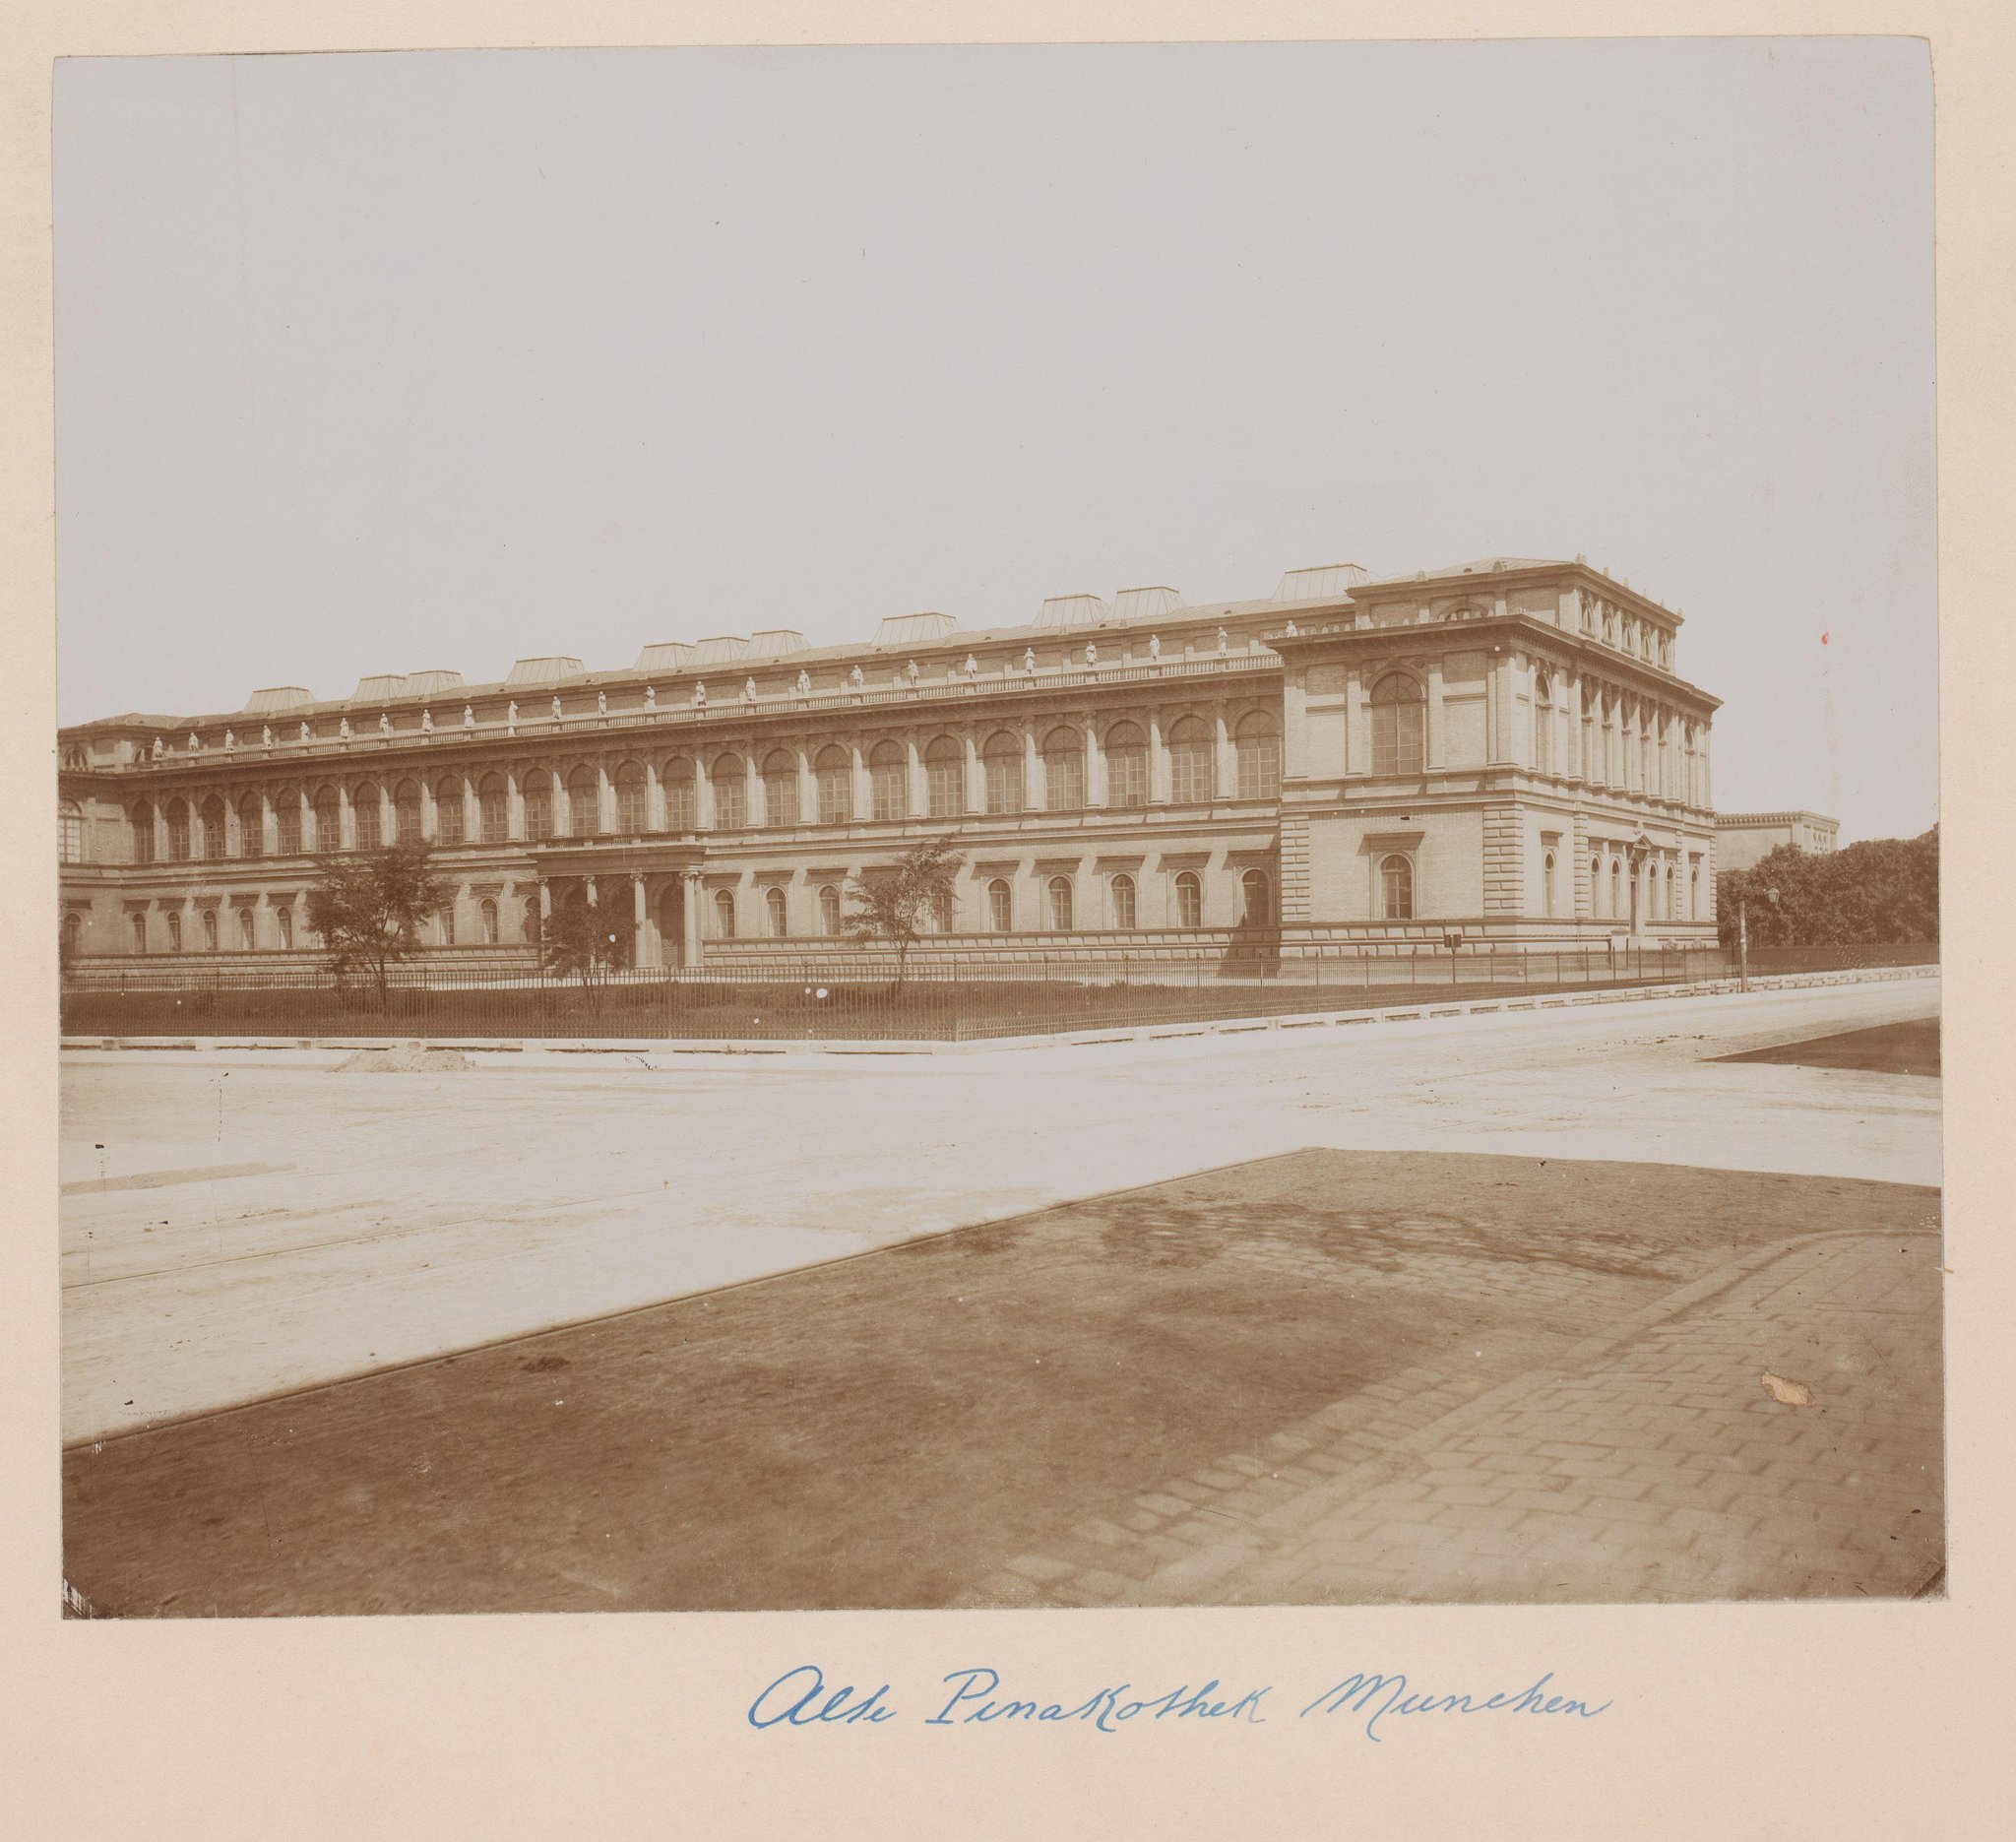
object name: photograph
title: Alte Pinakothek, München, Duitsland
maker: Anonymous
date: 1880-1910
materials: cardboard, photographic support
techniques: collodion silver print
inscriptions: inscription: ‘Alte Pinakothek Munchen [sic]’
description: Aanzicht van links vóór op de Alte Pinakothek, gebouwd door architect Leo von Klenze tussen 1826-1836 in opdracht van Lodewijk I die daar, evenals in de tegenover liggende Neue Pinakothek, zijn kunstverzameling aan de openbaarheid wilde tonen. In WO II sterk beschadigd en heropgebouwd tussen 1952-1957 door architect Hans Döllgast.